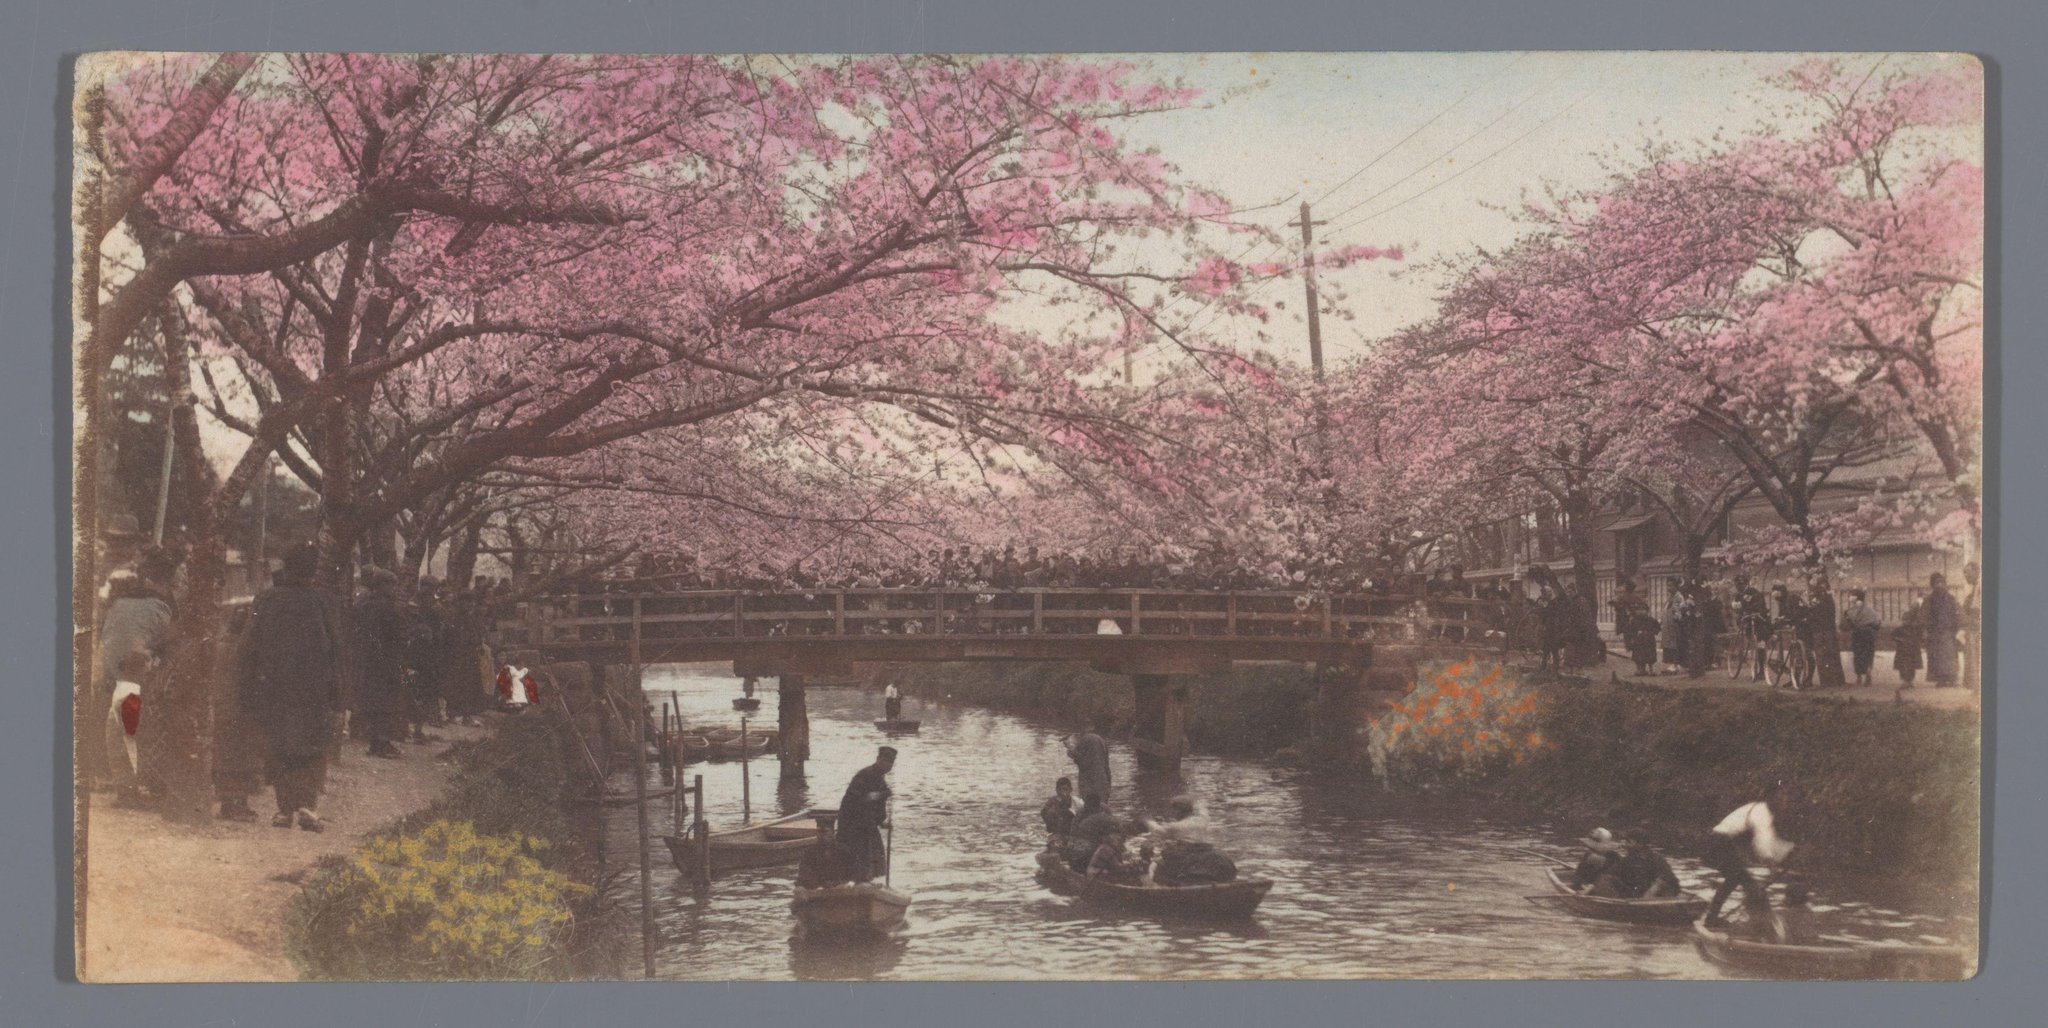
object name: photograph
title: Gezicht met brug, rivier en bootjes omzoomd door roze bloesem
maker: Anonymous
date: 1919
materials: photographic support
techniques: albumen print, hand coloring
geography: japan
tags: bridge in city across river, canal, etc., japan